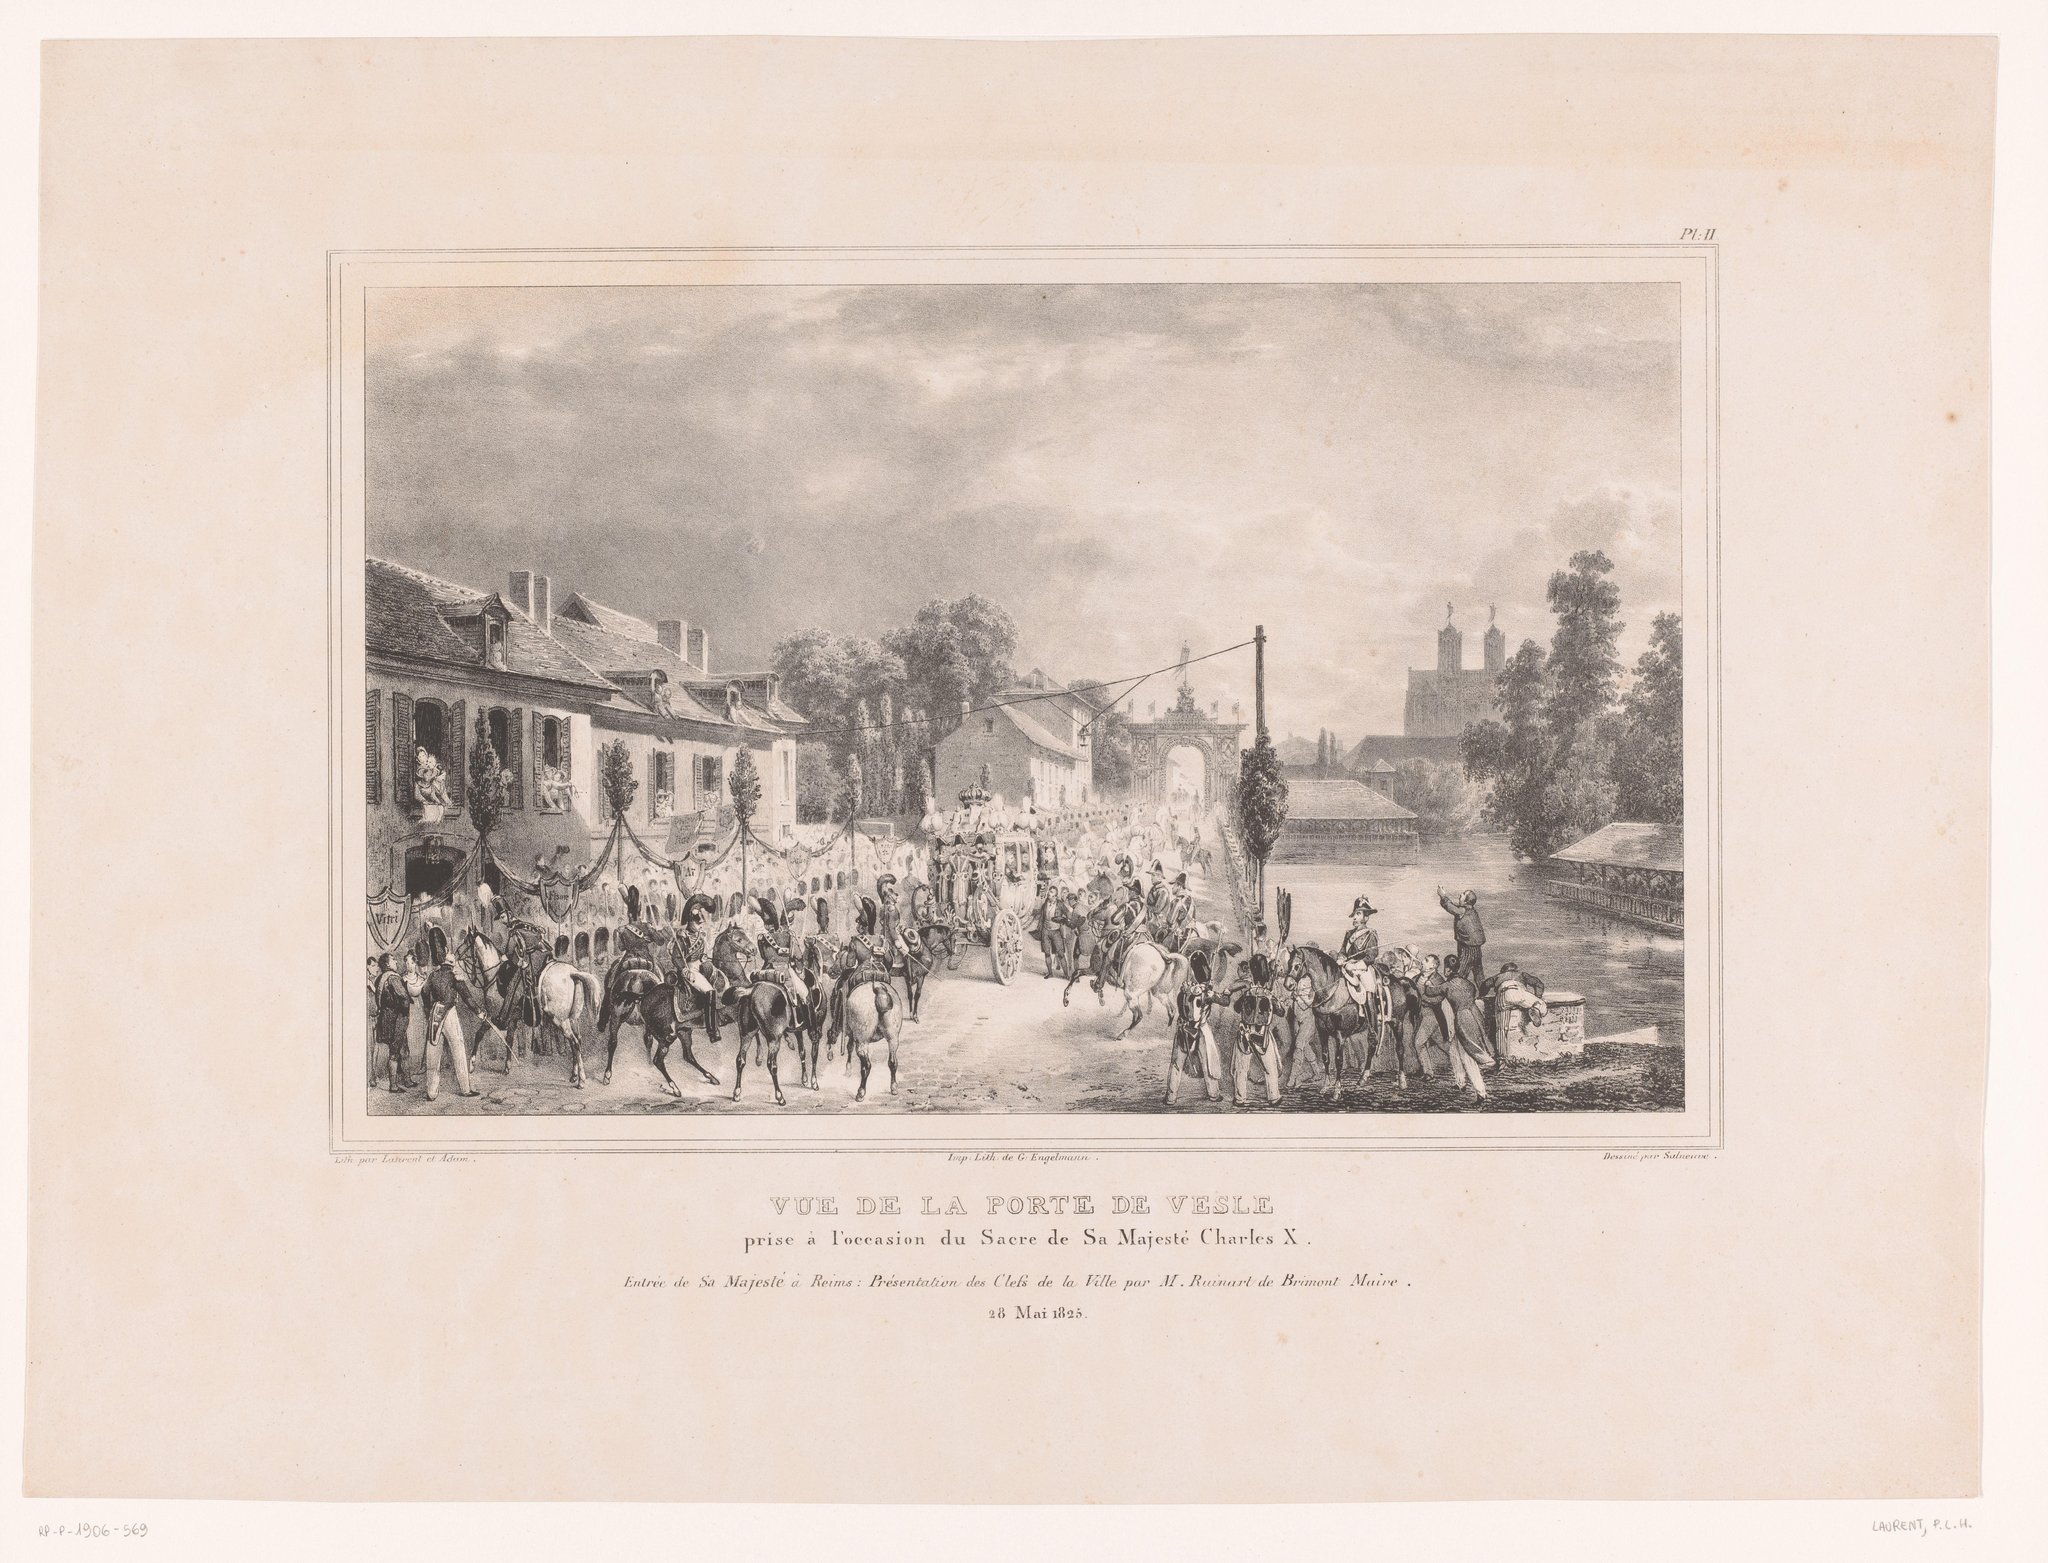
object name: print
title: Entree van Karel X van Frankrijk te Reims ter gelegenheid van zijn kroning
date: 1825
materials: paper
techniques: lithograph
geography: paris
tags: triumphal entry and public reception, pageant, 'entrée solennelle', 'joyeuse entrée', historical persons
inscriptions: collector's mark: Lugt 2228a